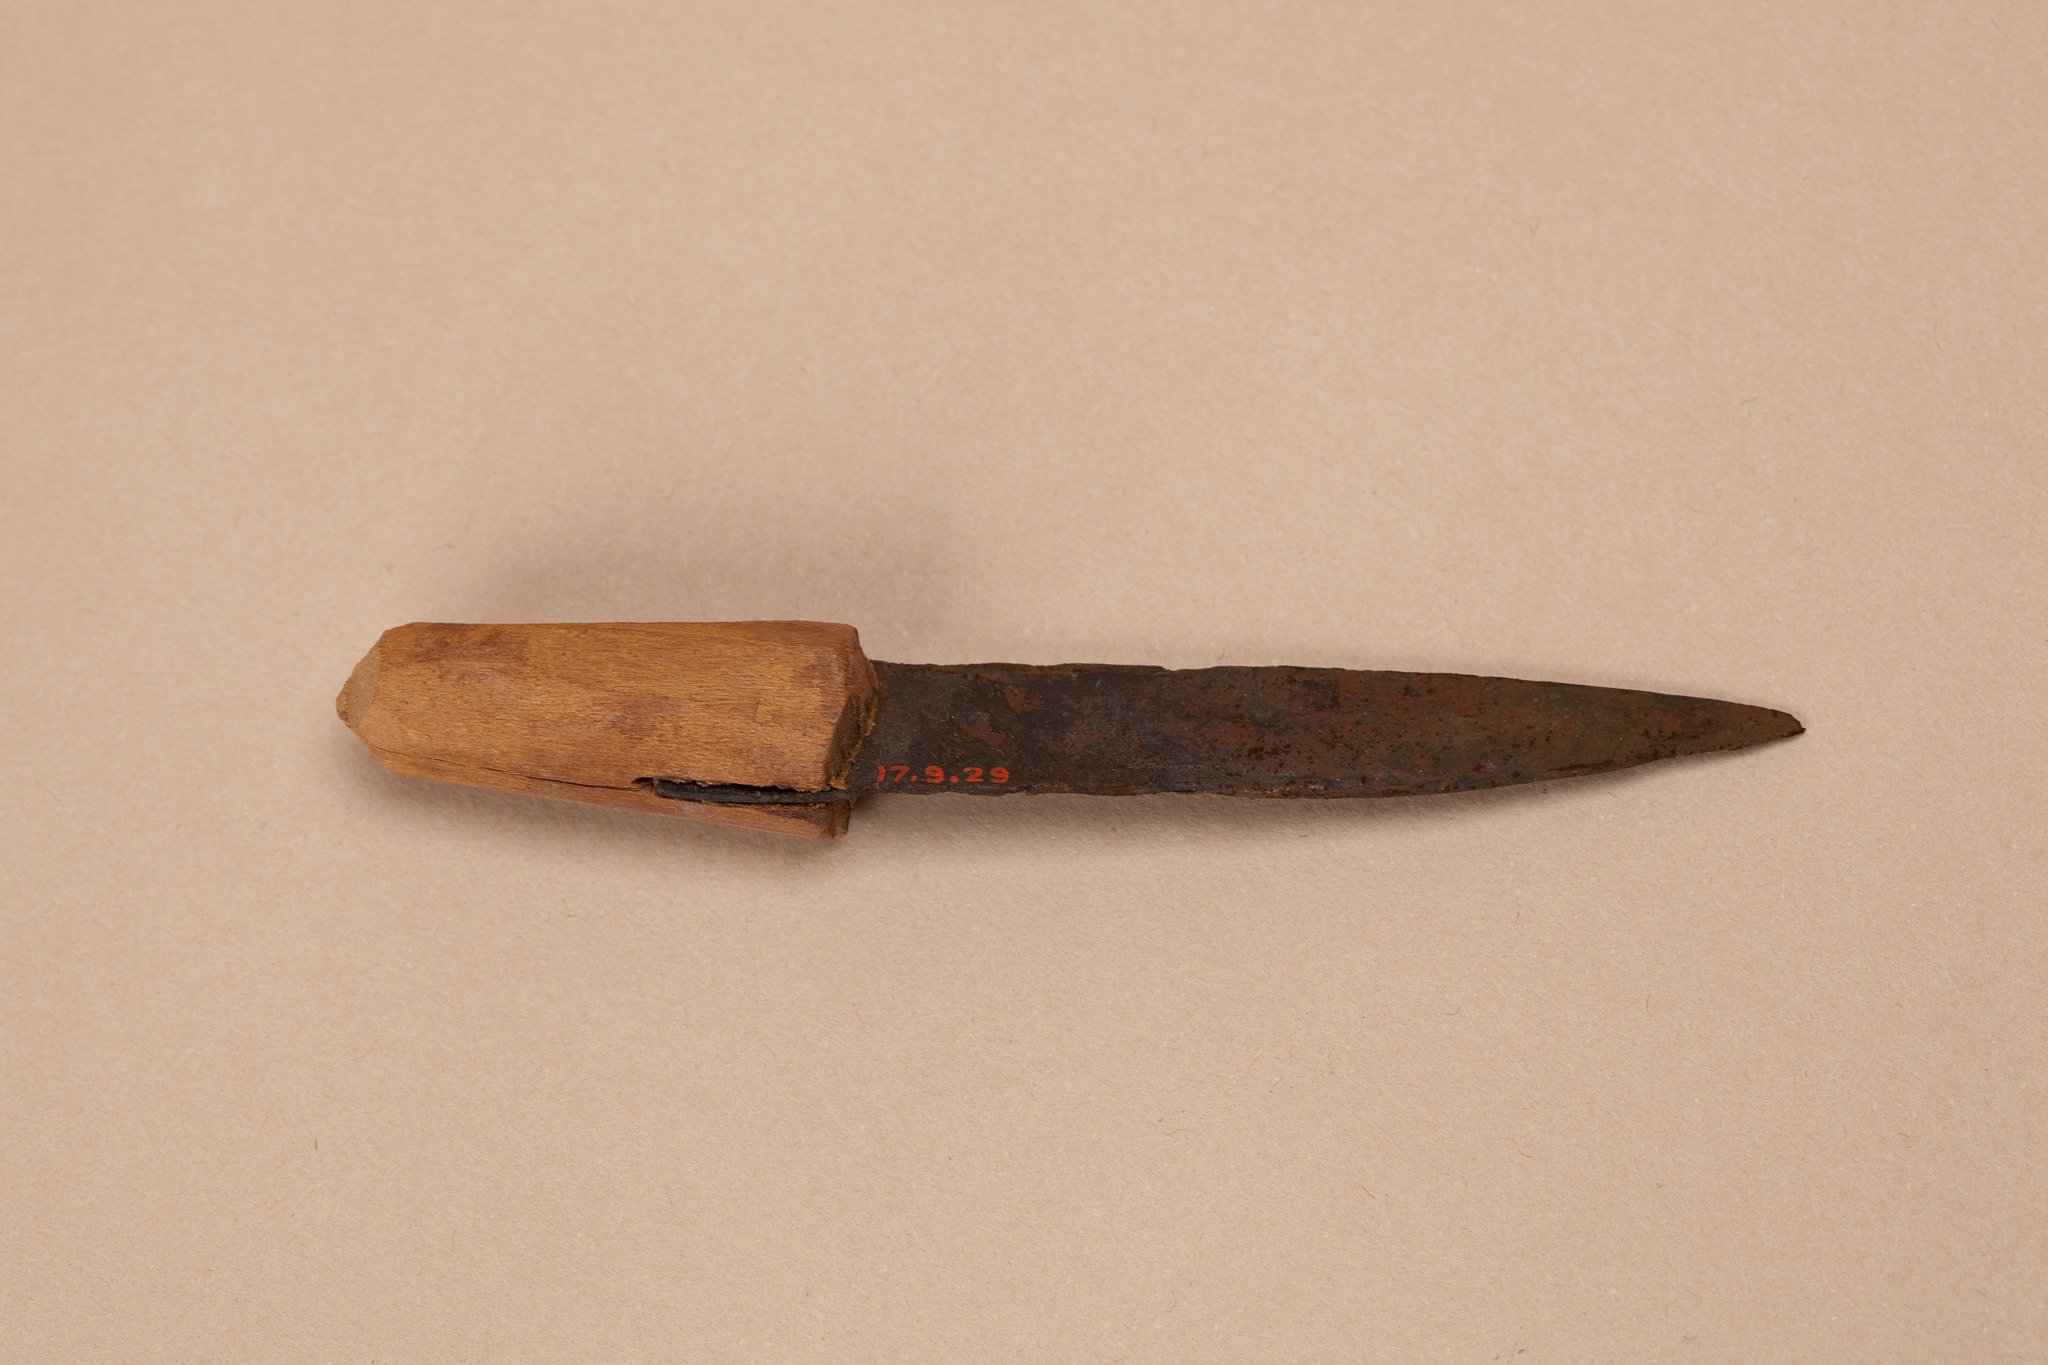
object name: model chisel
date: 1981-1802 BCE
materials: copper, wood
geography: egypt